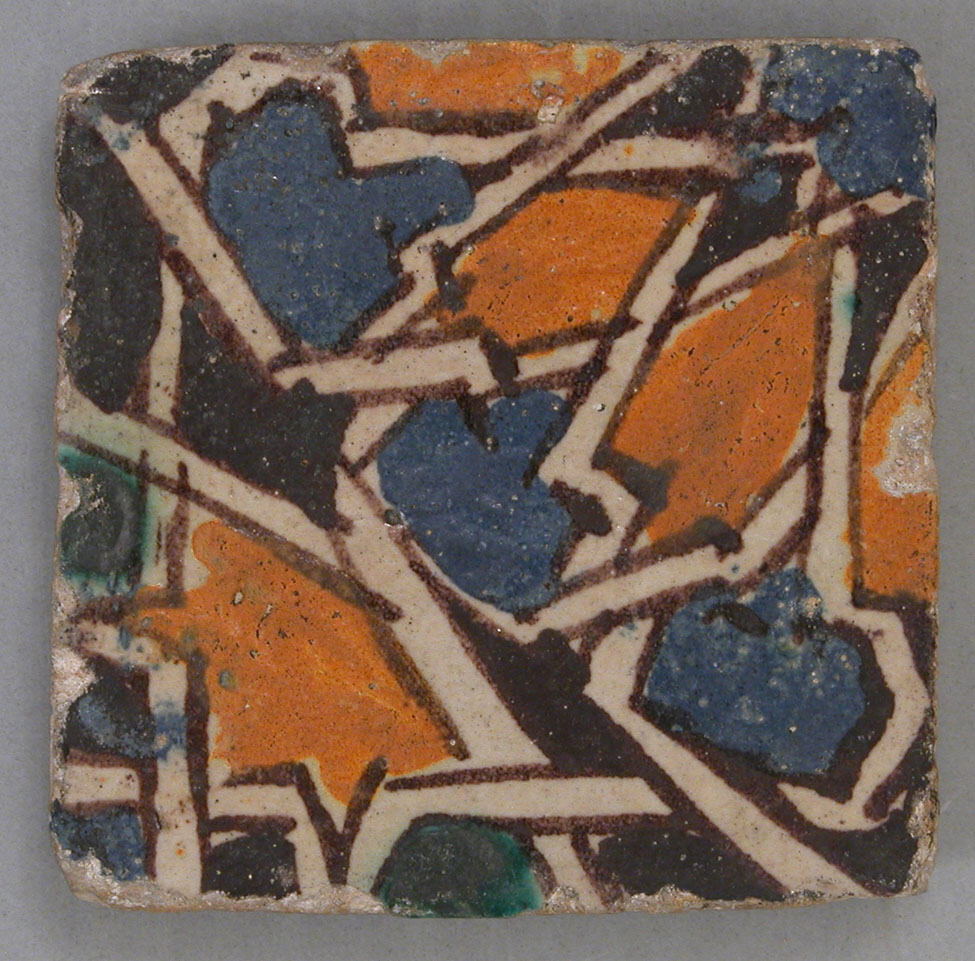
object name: tile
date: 1301-1500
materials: stonepaste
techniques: glazing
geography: tunisia